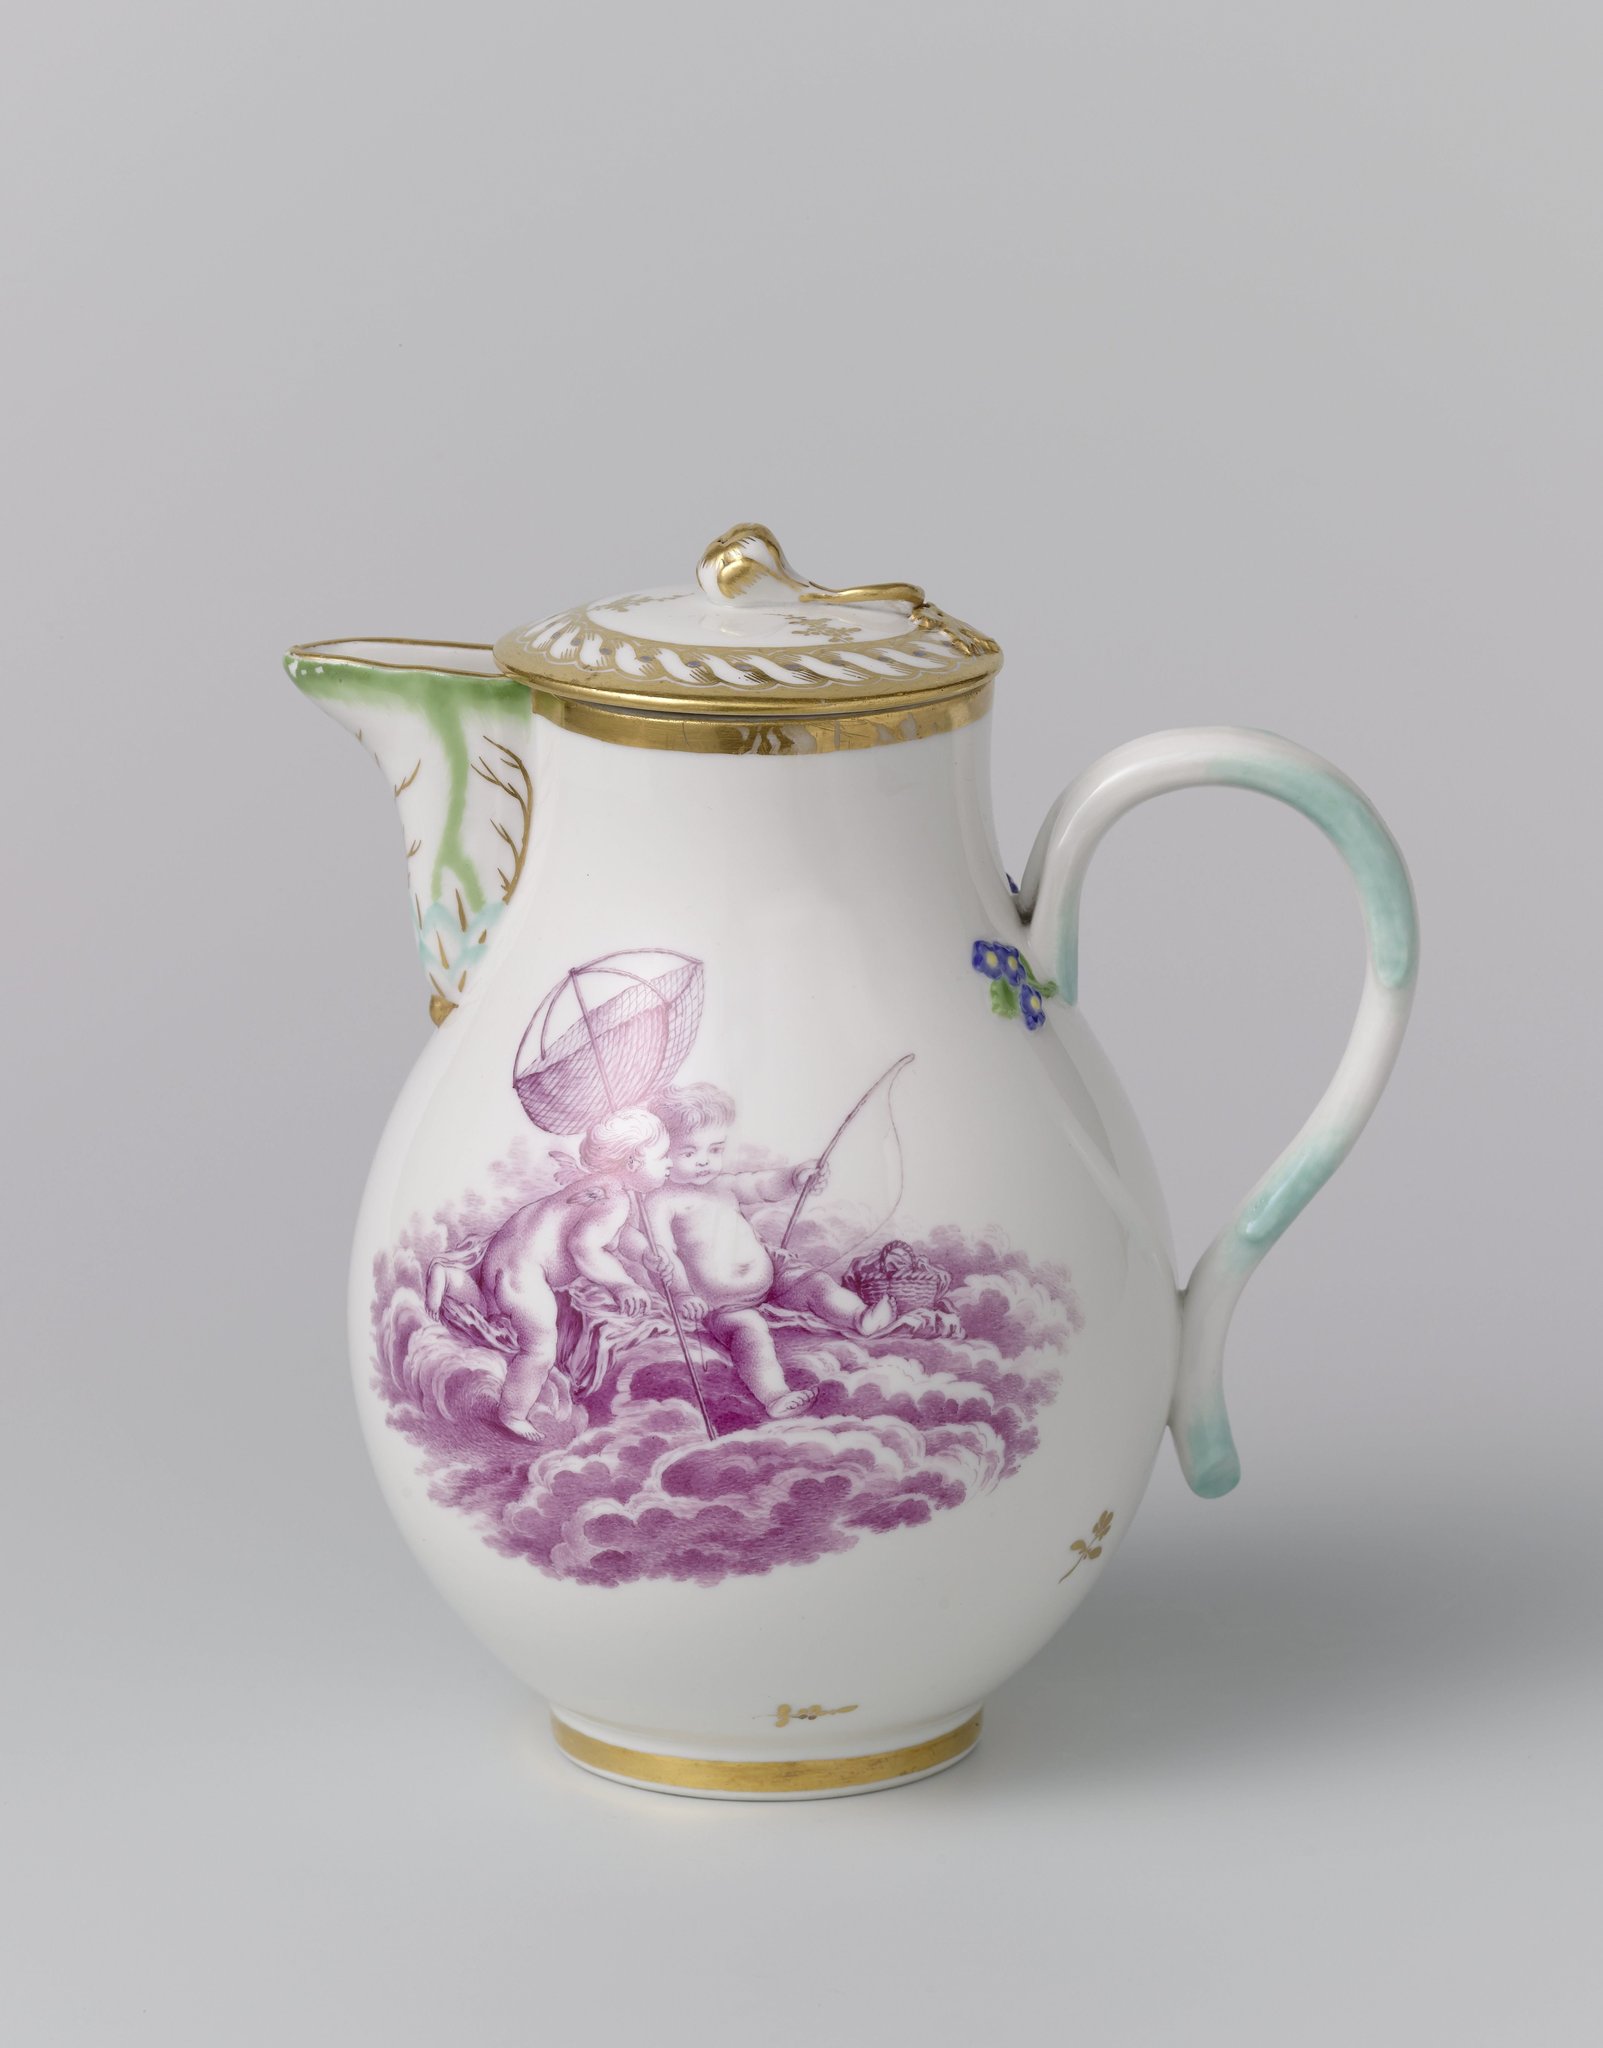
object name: service set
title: Milk jug with putti on clouds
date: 1785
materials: glaze, gold, paint, porcelain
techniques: firing, forming, gilding, turning, vitrification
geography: germany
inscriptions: mark: ‘ooievaar’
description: Melkkan van porselein met een peervormig lichaam, driehoekige tuit vanuit de nek en C-vormig oor, beschilderd op het glazuur in blauw, roze, groen, geel en goud. Op de buik tweemaal een voorstelling in camaïeu van putti op wolken. De ene met twee vissende putti, de ander met een putto kijkend naar twee vogels. Om de voorstellingen strooibloemen in goud. De tuit is aan de onderzijde gemodelleerd in een bloem, met daarboven enkele vakken met een tak. Het oor met lichtblauwe vlekken en de basis met gemodelleerde bloemen. De deksel met dezelfde decoratie met op de rand een gedraaide band en guirlandes; dekselknop in de vorm van een bloem. Gemerkt op de onderzijde met de ooievaar.